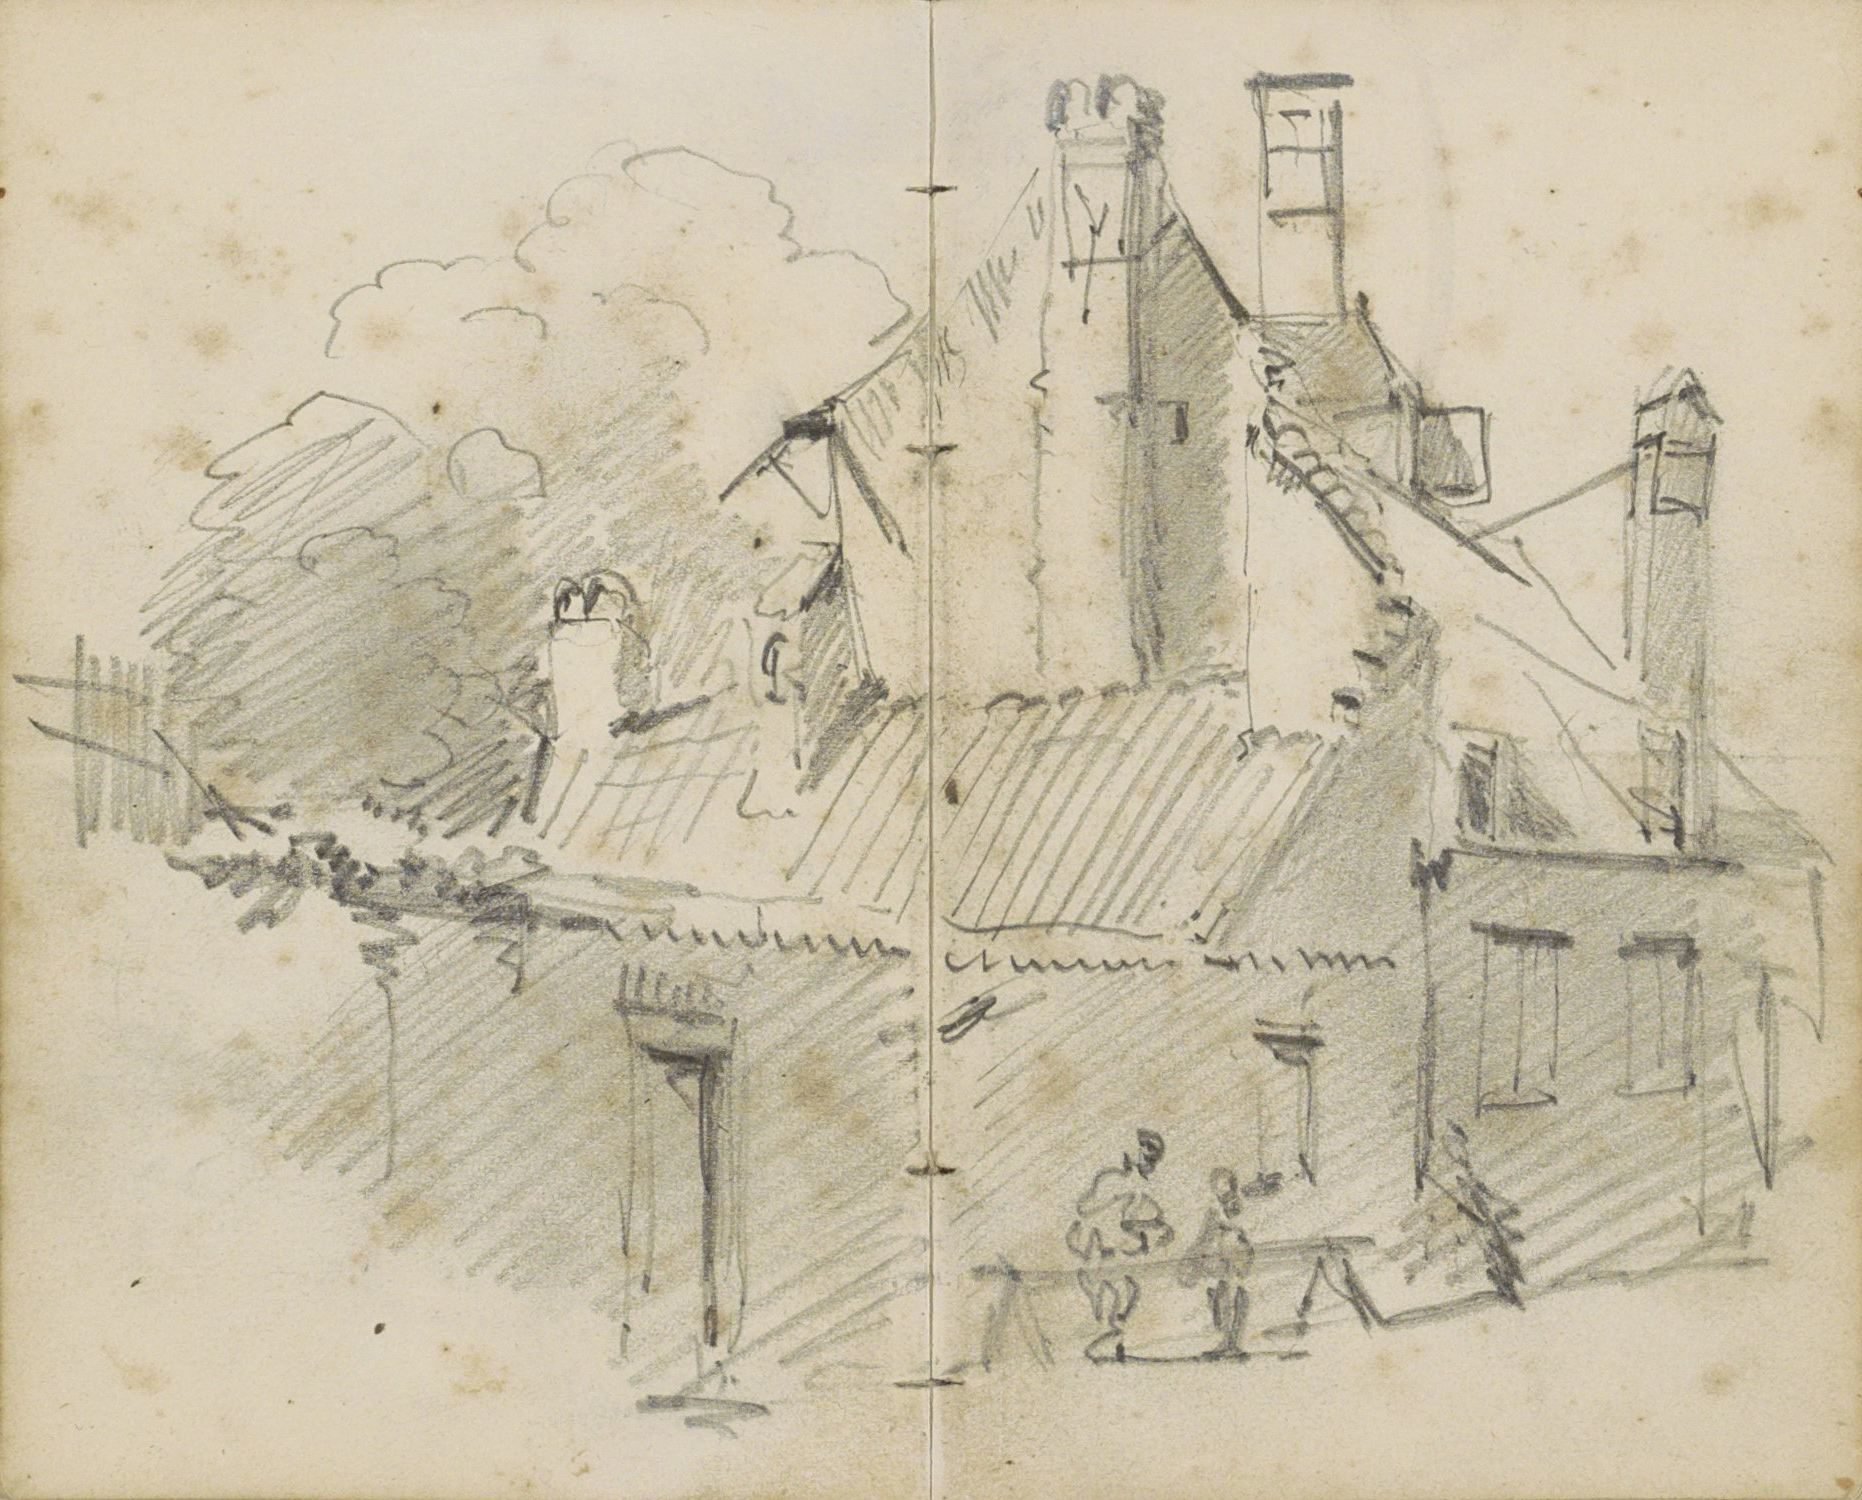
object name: sketchbook leaf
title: Straat met figuren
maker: willem koekkoek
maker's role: draughtsman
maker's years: 1839-1895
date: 1849-1895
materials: paper, pencil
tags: street (+ city(-scape) with figures, staffage)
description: Blad 45 verso 46 recto uit een schetsboek met 57 bladen.